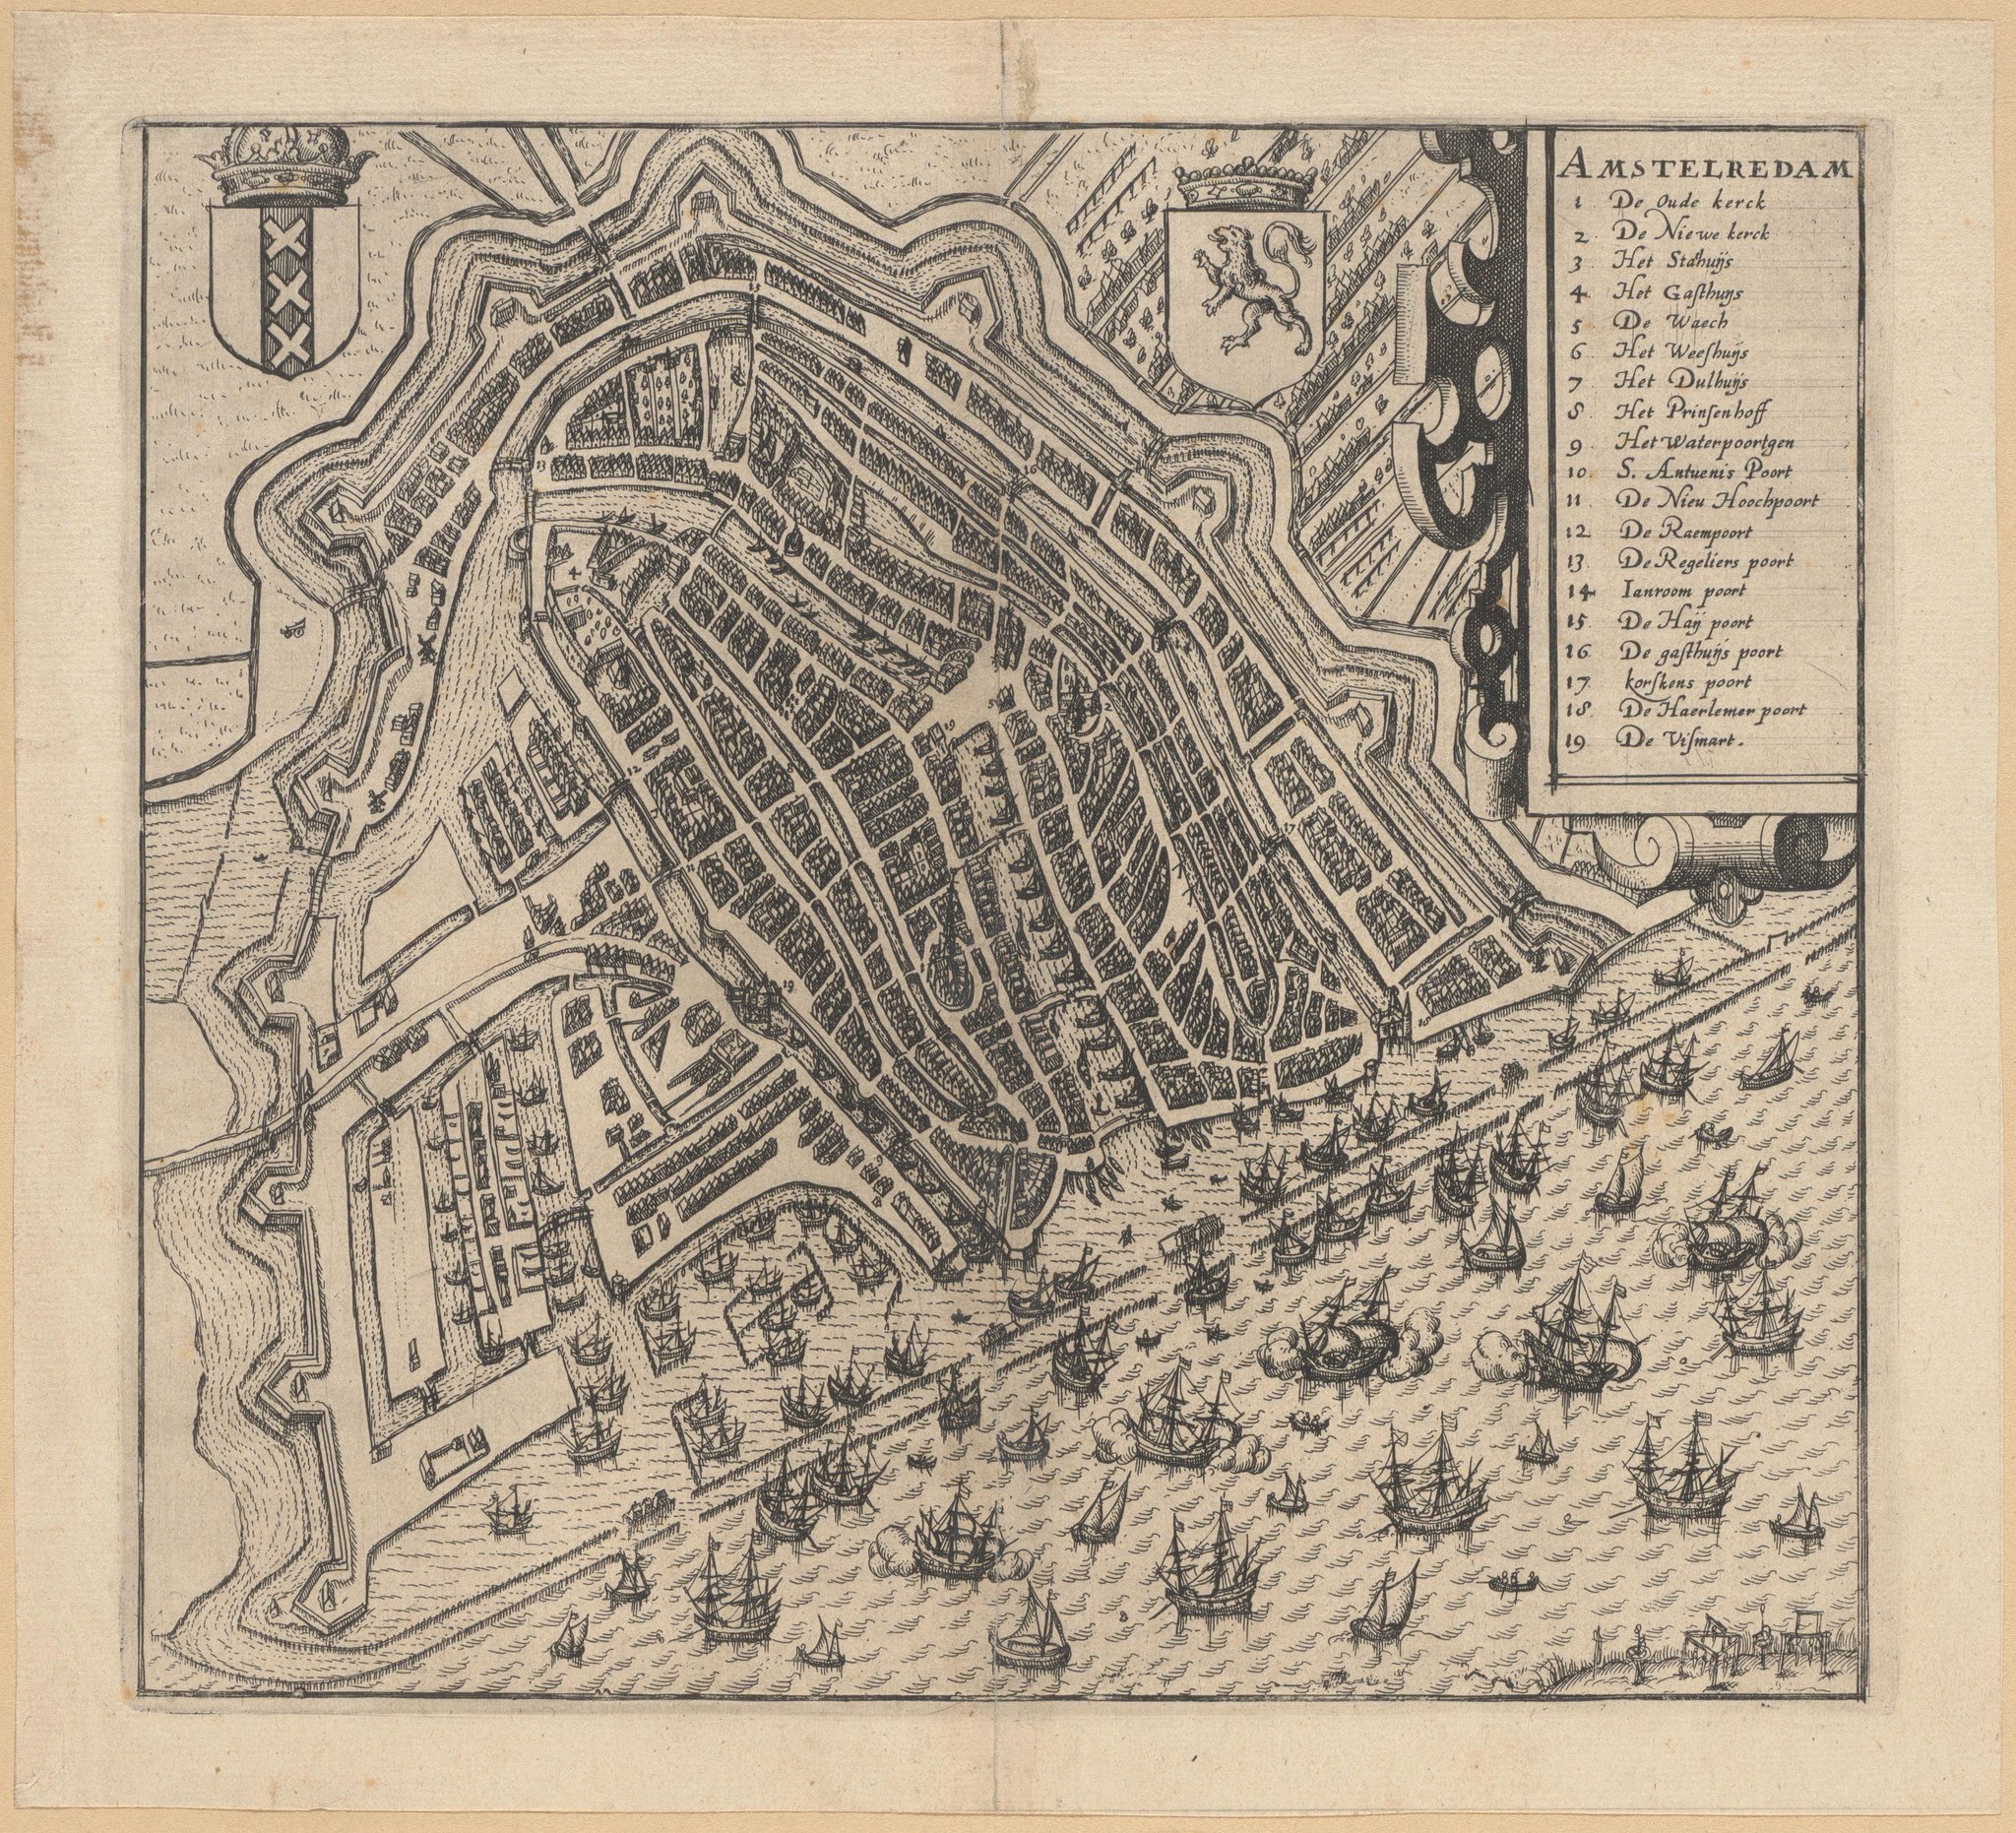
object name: map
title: Amstelredam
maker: Anonymous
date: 1609-1612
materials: paper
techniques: engraving, etching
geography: amsterdam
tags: coat of arms (as symbol of the state, etc.) (+ city; municipal), maps of cities, coat of arms (as symbol of the state, etc.) (+ province; provincial), amsterdam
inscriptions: collector's mark: Lugt 1641b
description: Prent mogelijk uit: Guicciardini, Lodovico. Description de touts les Pays-Bas, autrement appellez la Germanie Inferieure, ou Basse Allemagne. Amsterdam: Cornelis Claesz., 1609. Of uit latere edities (en vertalingen) van 1609 en 1612, uitgegeven door Abraham Maire en Willem Janszoon Blaeu.